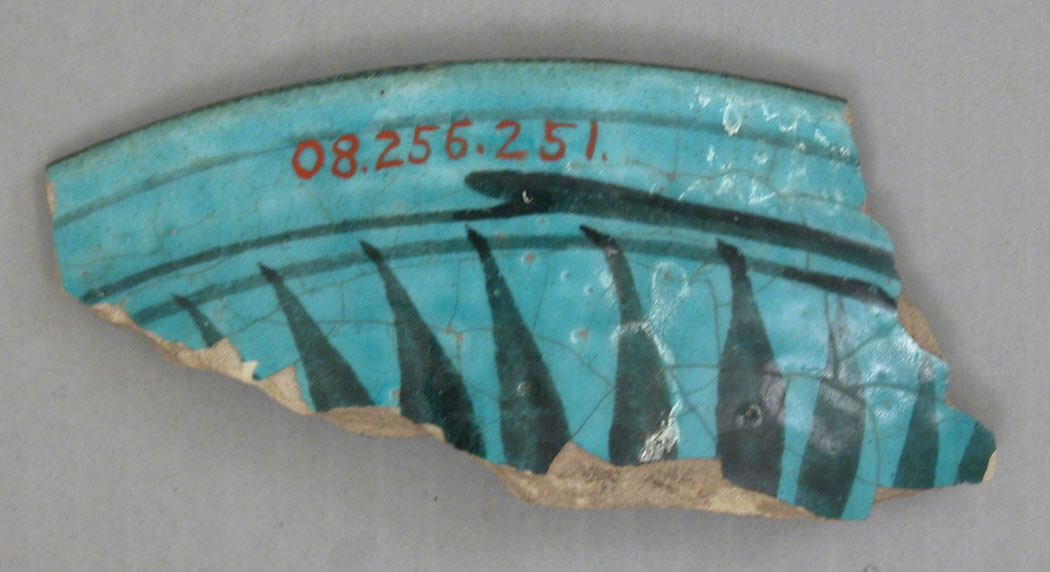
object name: fragment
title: Ceramic Fragment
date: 1301-1500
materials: stonepaste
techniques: painting, underglaze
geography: syria